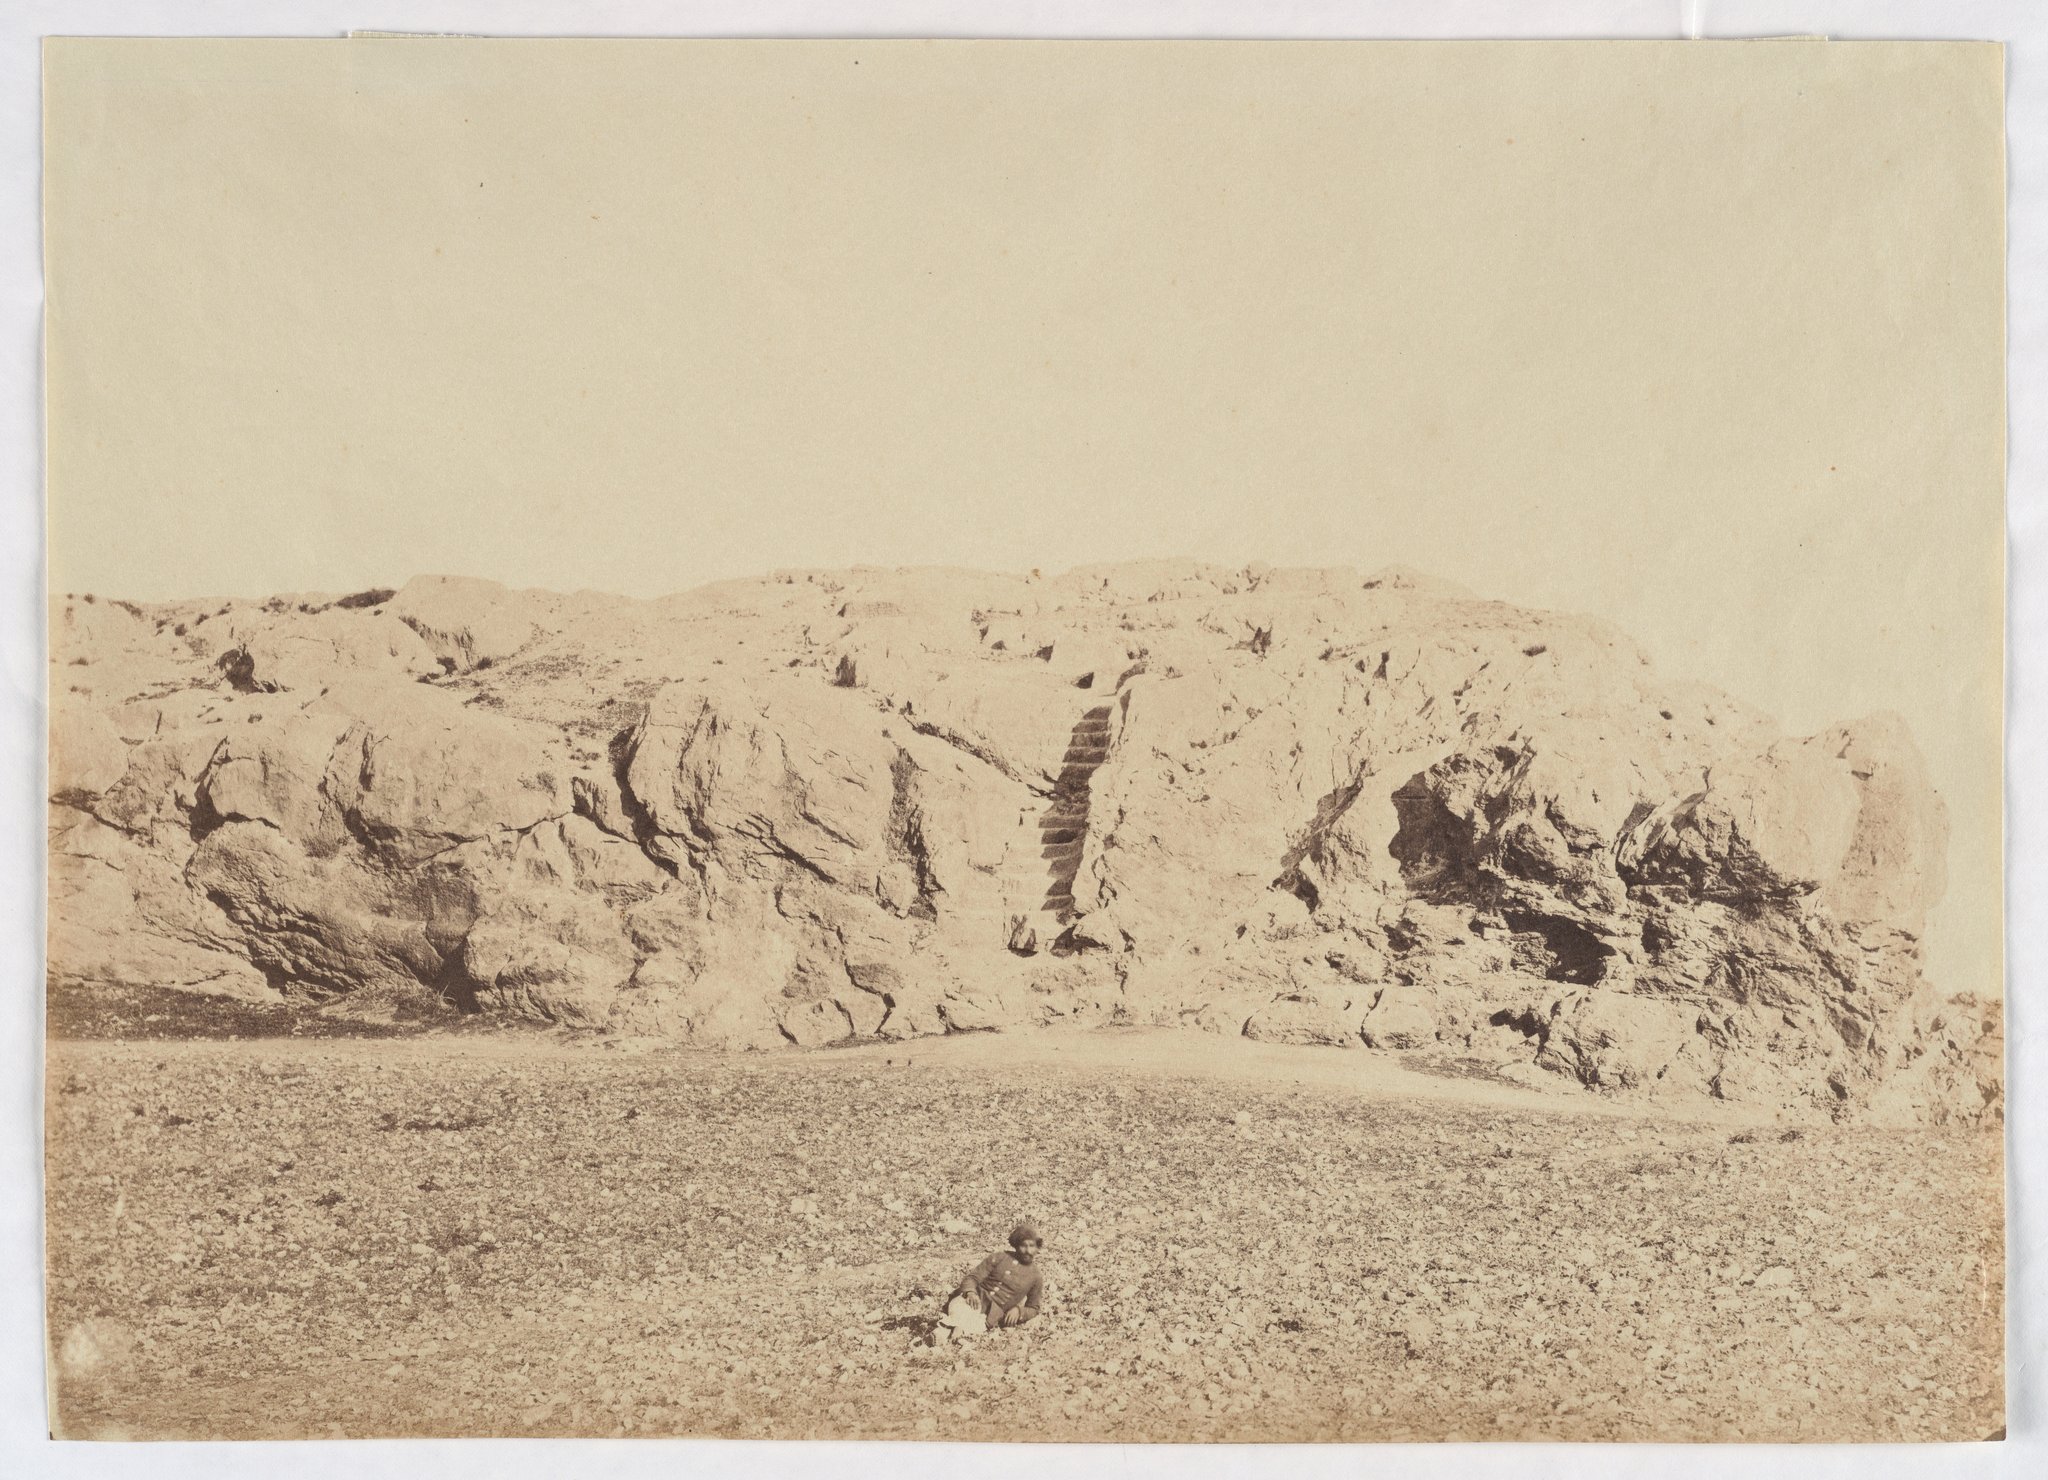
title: [Acropolis, Athens, Greece]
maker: james robertson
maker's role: artist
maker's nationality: british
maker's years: 1813-1881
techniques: salted paper print